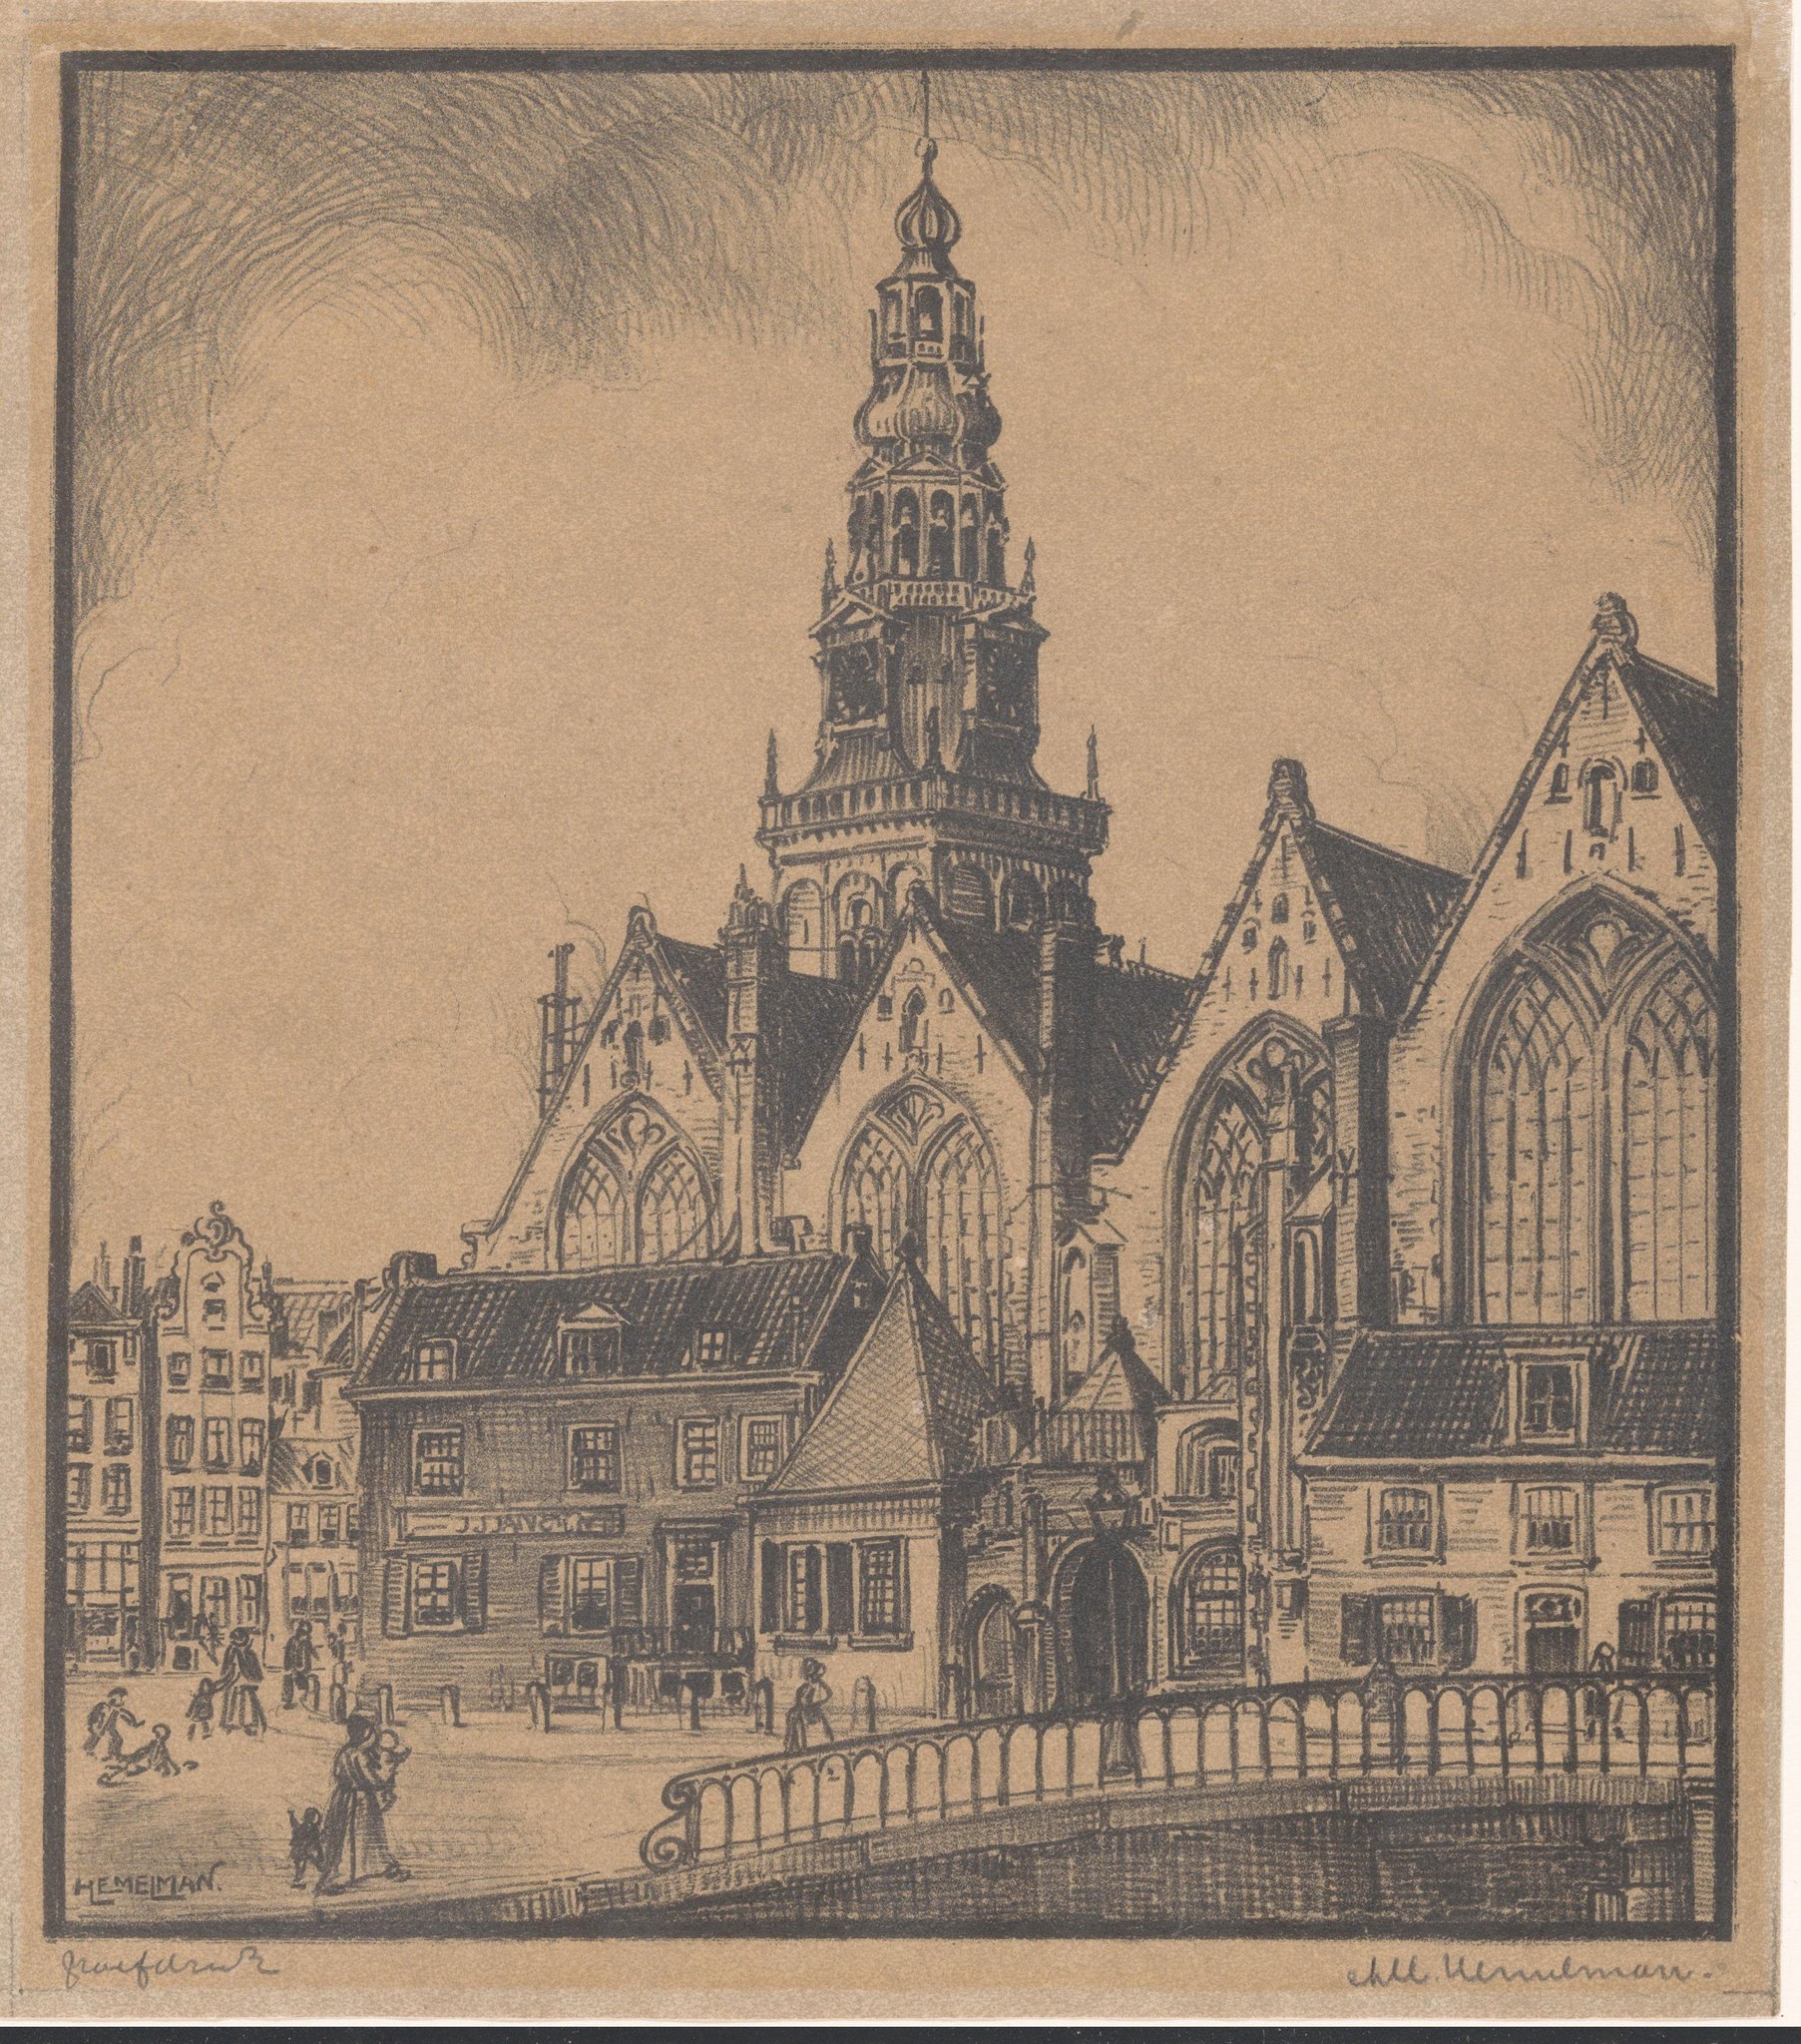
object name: print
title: Achter de Oude Kerk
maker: albert hemelman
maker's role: draughtsman, print maker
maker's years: 1883-1951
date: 1902-1951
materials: paper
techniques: lithograph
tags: church (exterior), city-view in general; 'veduta' (+ city(-scape) with figures, staffage)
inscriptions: signature: ‘Alb Hemelman’, signature: ‘HEMELMAN’, edition: ‘proefdruk’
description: Torenspits en kapellen van de Oude Kerk te Amsterdam, op de voorgrond een brugleuning.